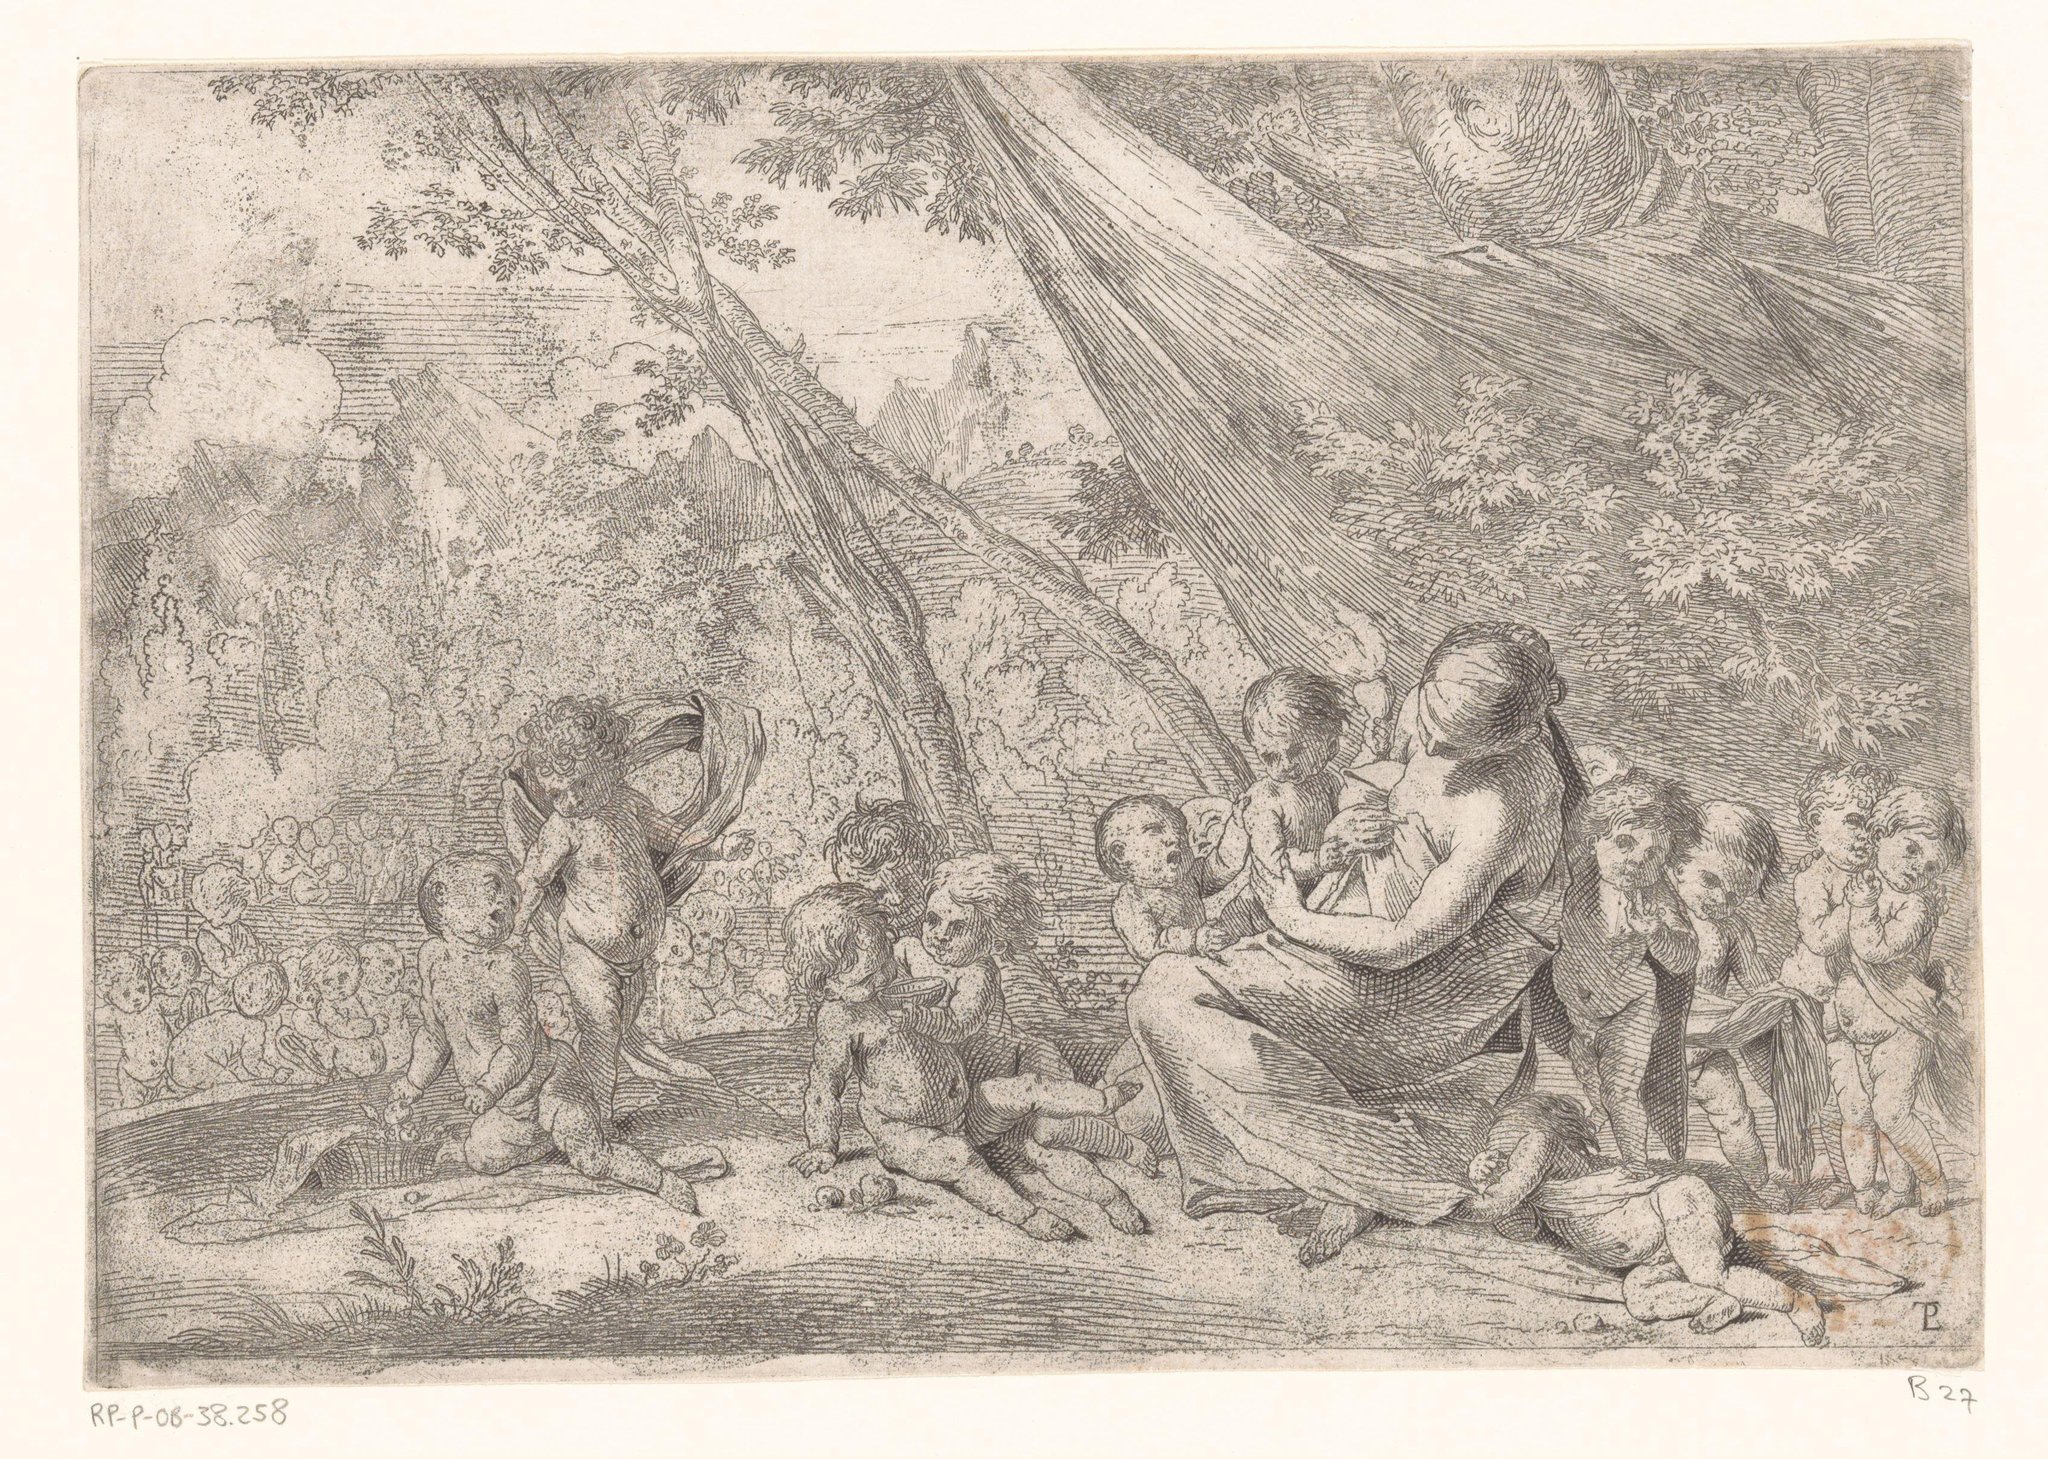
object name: print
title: Tuin van Caritas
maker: pietro testa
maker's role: draughtsman, painter, print maker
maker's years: 1611-1650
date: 1630-1631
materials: paper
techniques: etching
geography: italy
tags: charity, 'caritas'; 'carità' (ripa) ~ one of the three theological virtues, cupids: 'amores', 'amoretti', 'putti'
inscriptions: collector's mark: Lugt 240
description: Een personificatie van de liefde (Caritas), zittend in een tuin en omgeven door putti.